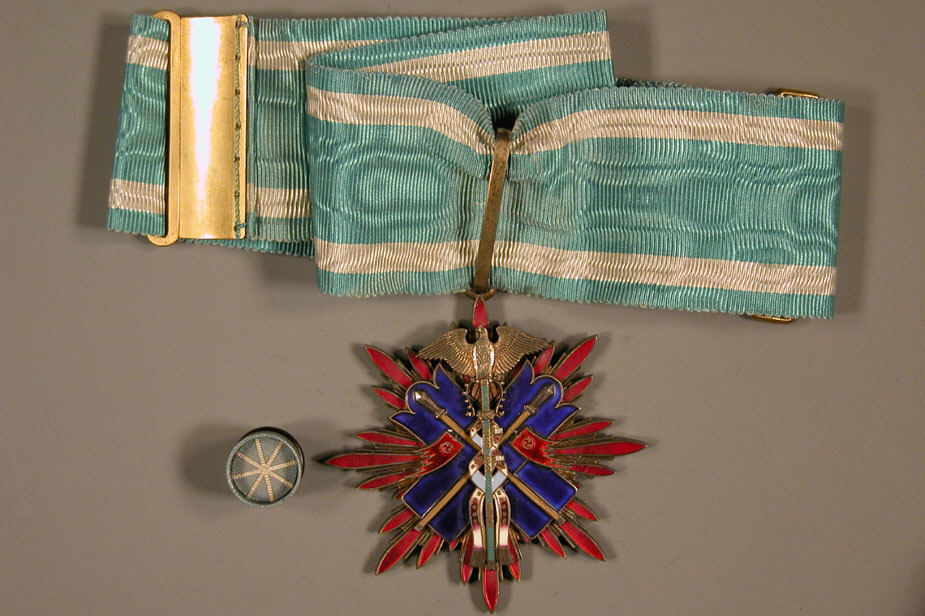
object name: medal and button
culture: japanese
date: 1867-1900